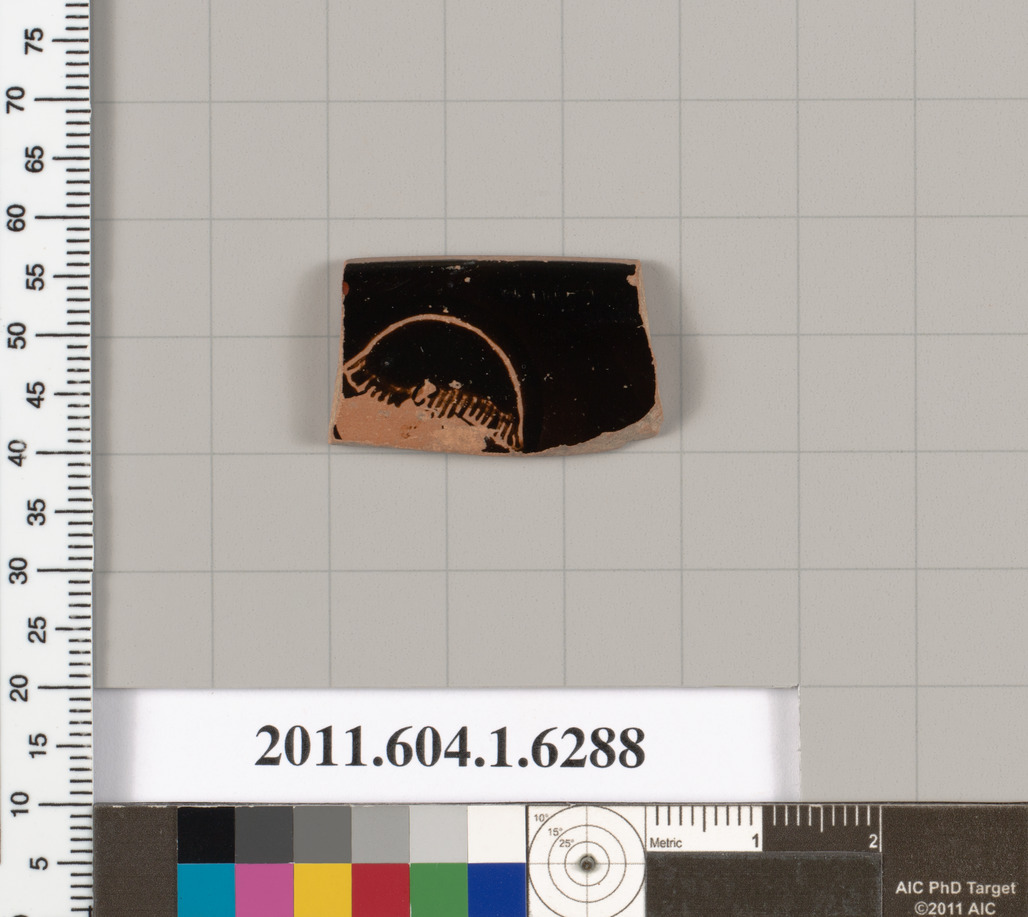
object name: kylix fragment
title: Terracotta rim fragment of a kylix (drinking cup)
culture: greek, attic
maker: antiphonic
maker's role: artist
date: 500-480 BCE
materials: terracotta